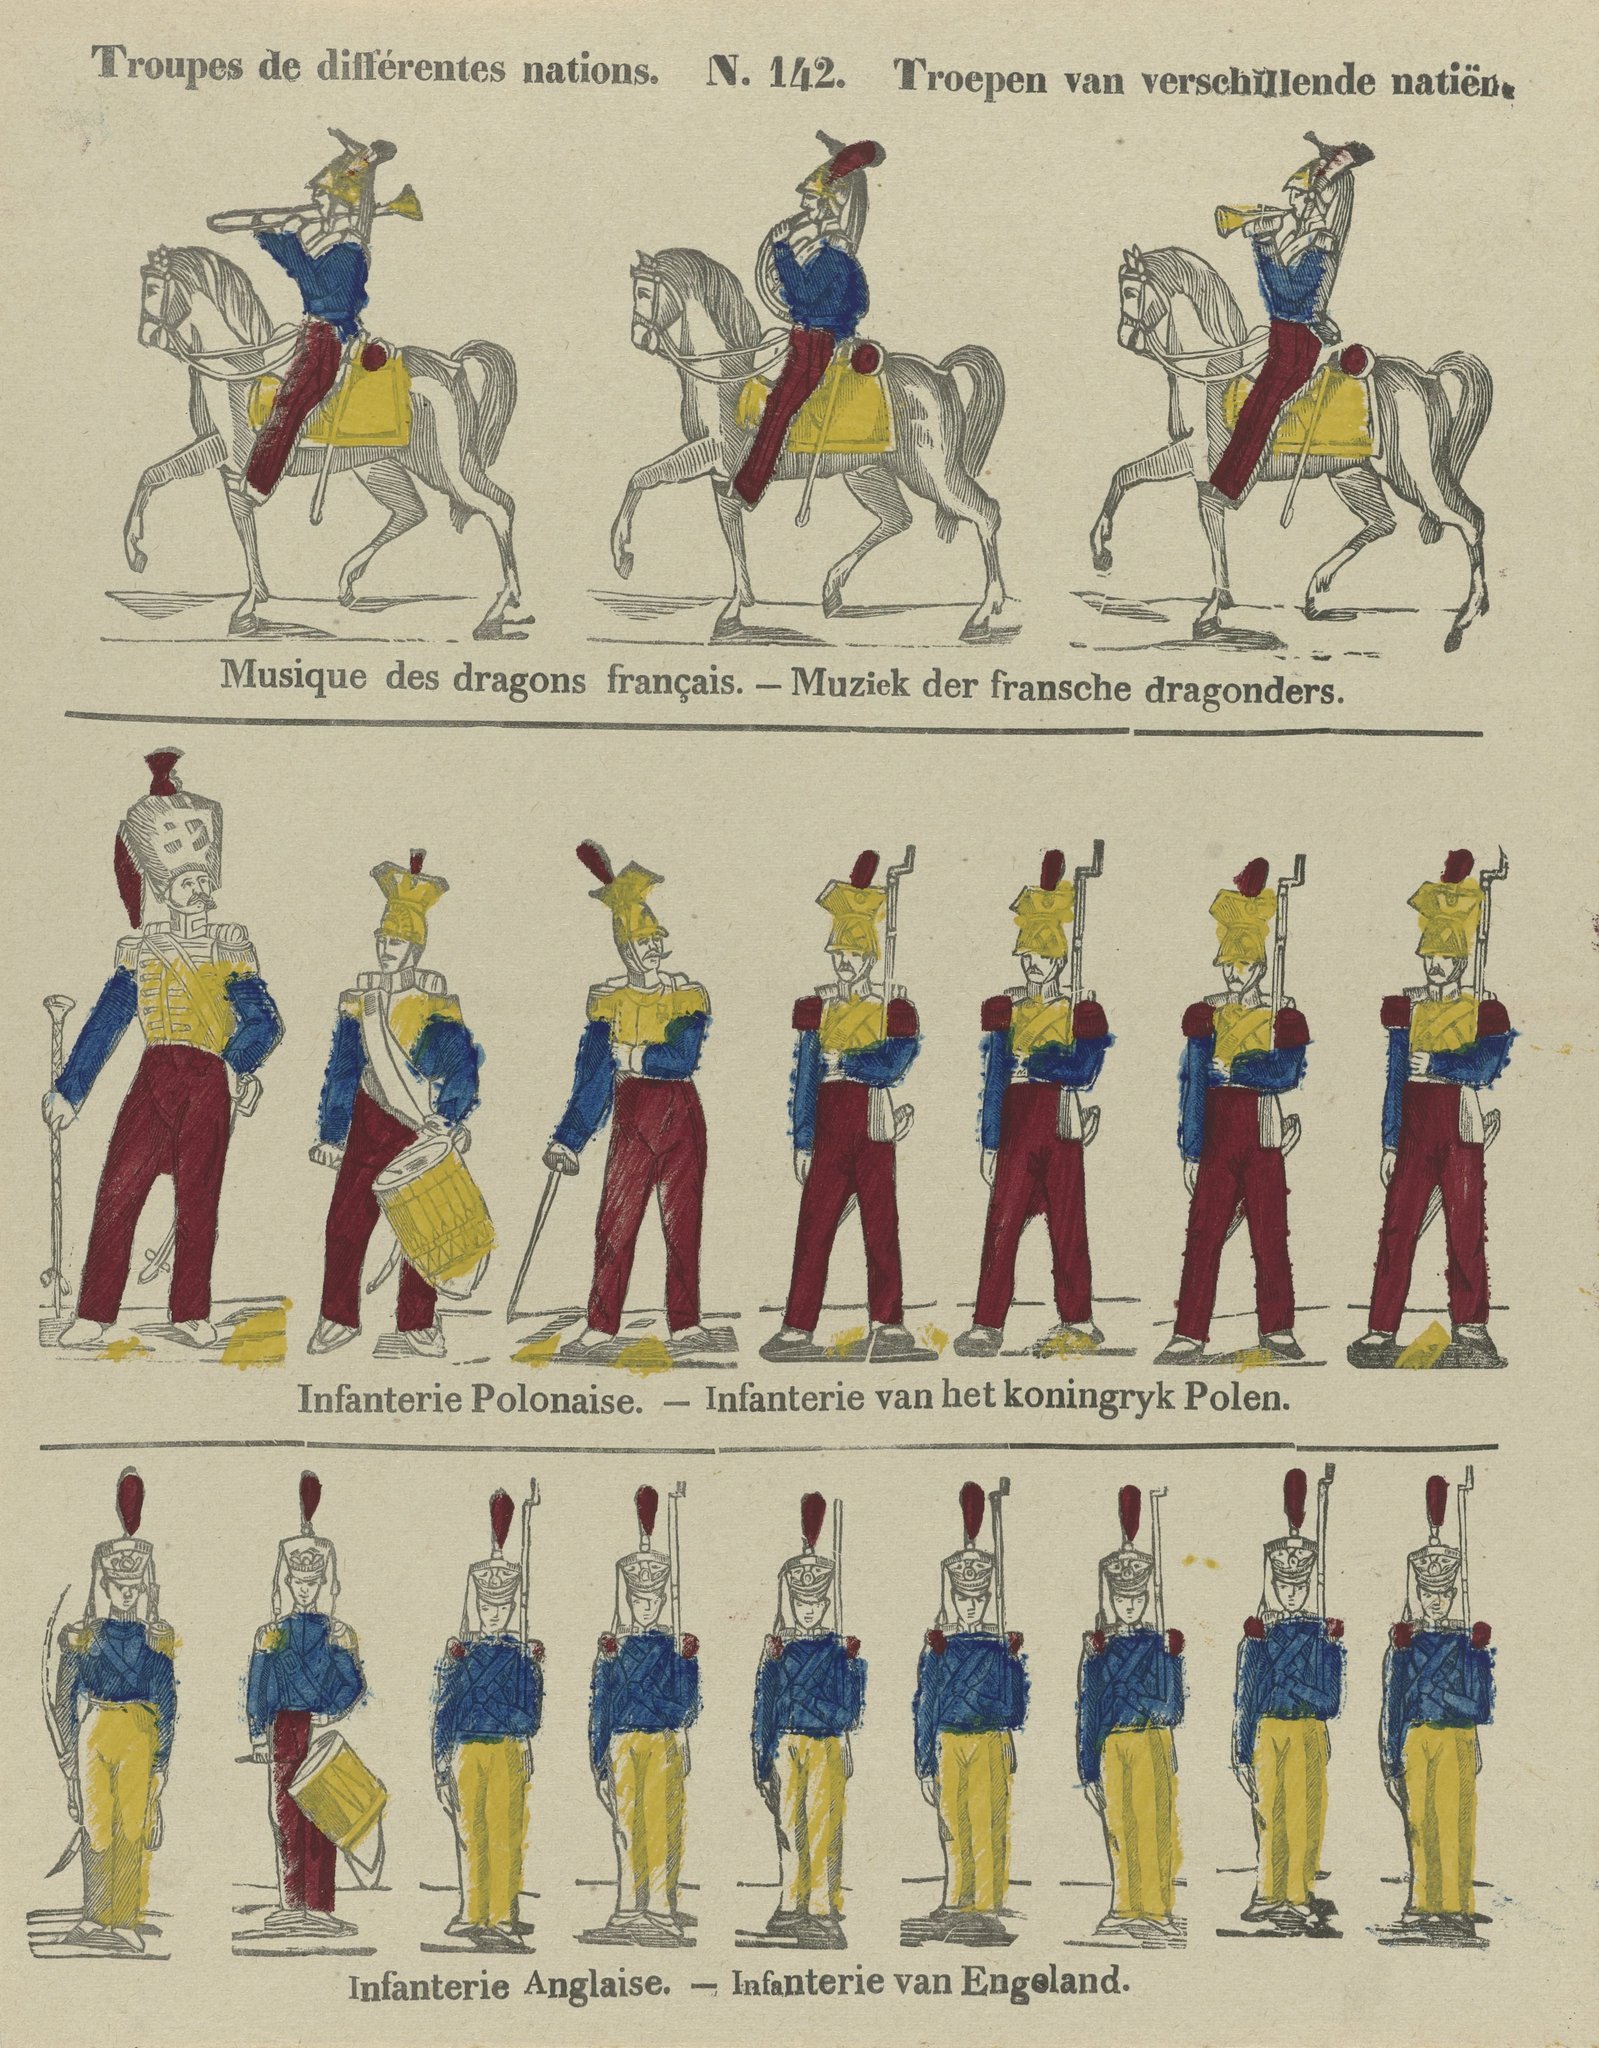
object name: print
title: Troupes de différentes nations / Troepen van verschillende natiën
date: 1800-1833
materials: paper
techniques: lithograph, letterpress printing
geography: turnhout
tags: military band, the soldier; the soldier's life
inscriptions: collector's mark: Lugt 2760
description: Blad met 3 horizontale rijen met voorstellingen van Poolse, Franse en Engelse soldaten. Onder elke afbeeldingen een onderschrift in het Nederlands en in het Frans. Genummerd midden boven: N. 142.